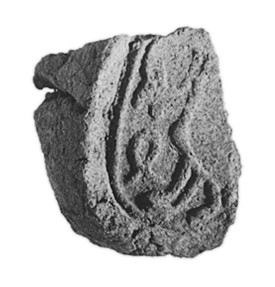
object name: sealing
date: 2030-1640 BCE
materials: clay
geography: egypt